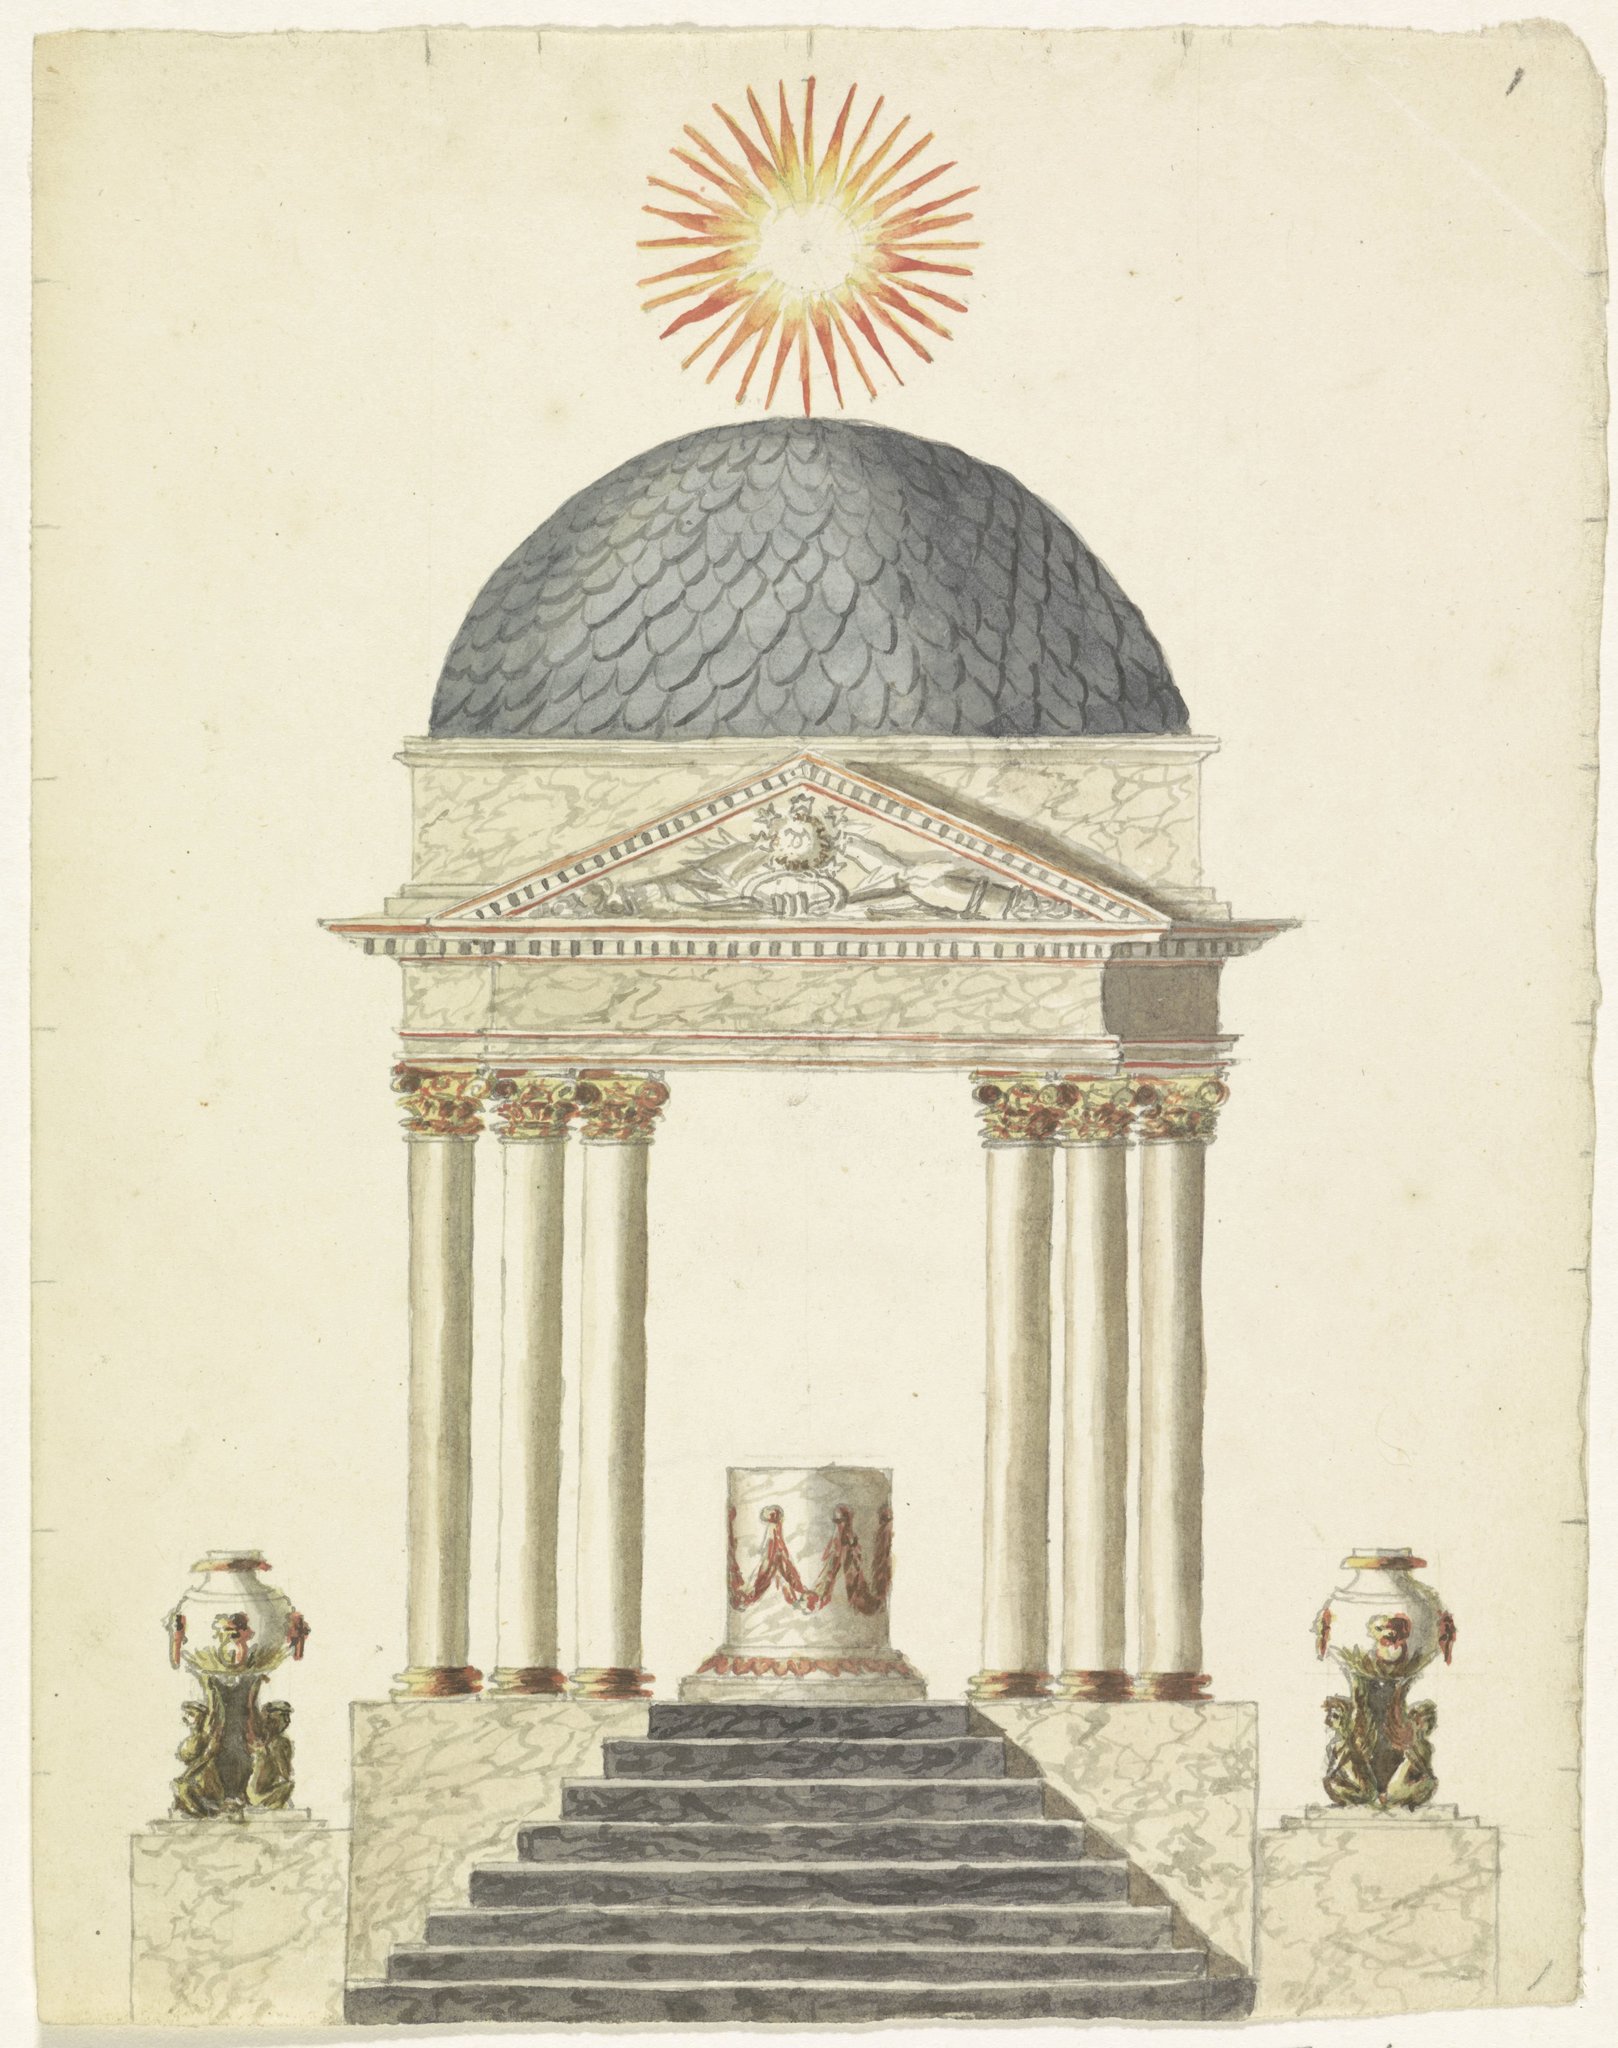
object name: drawing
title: Tekeningen van de decoraties te Amsterdam bij het bezoek van de prins en prinses, 1816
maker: Anonymous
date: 1816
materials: paper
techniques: brush, pen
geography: netherlands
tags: anna paulowna romanowa, the hague, william ii of the netherlands, public festivities on the occasion of royal events (+ decorated staff, portable structure ~ festive activities), triumphal arch, amsterdam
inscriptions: collector's mark: Lugt 2228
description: Erepoort in de vorm van een tempel met koepel en zes zuilen, met bovenop een stralende zon. Opgericht bij de Haarlemmerpoort. Onderdeel van een serie van 14 (van de 16) tekeningen voor de decoraties opgesteld bij het bezoek van de prins en prinses van Oranje aan Amsterdam op 19 september 1816.